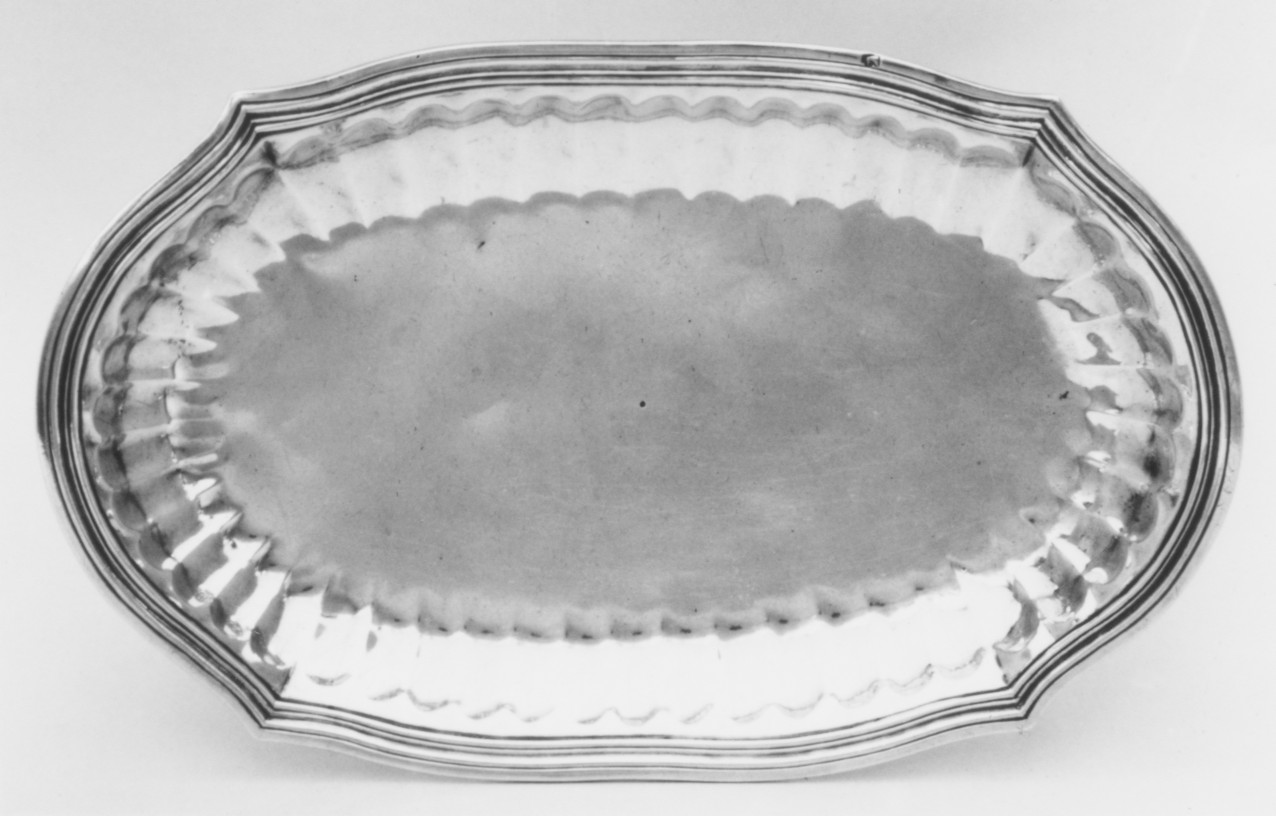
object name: tray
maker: pierre hugé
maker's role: maker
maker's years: 1712-1765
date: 1744-1745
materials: silver